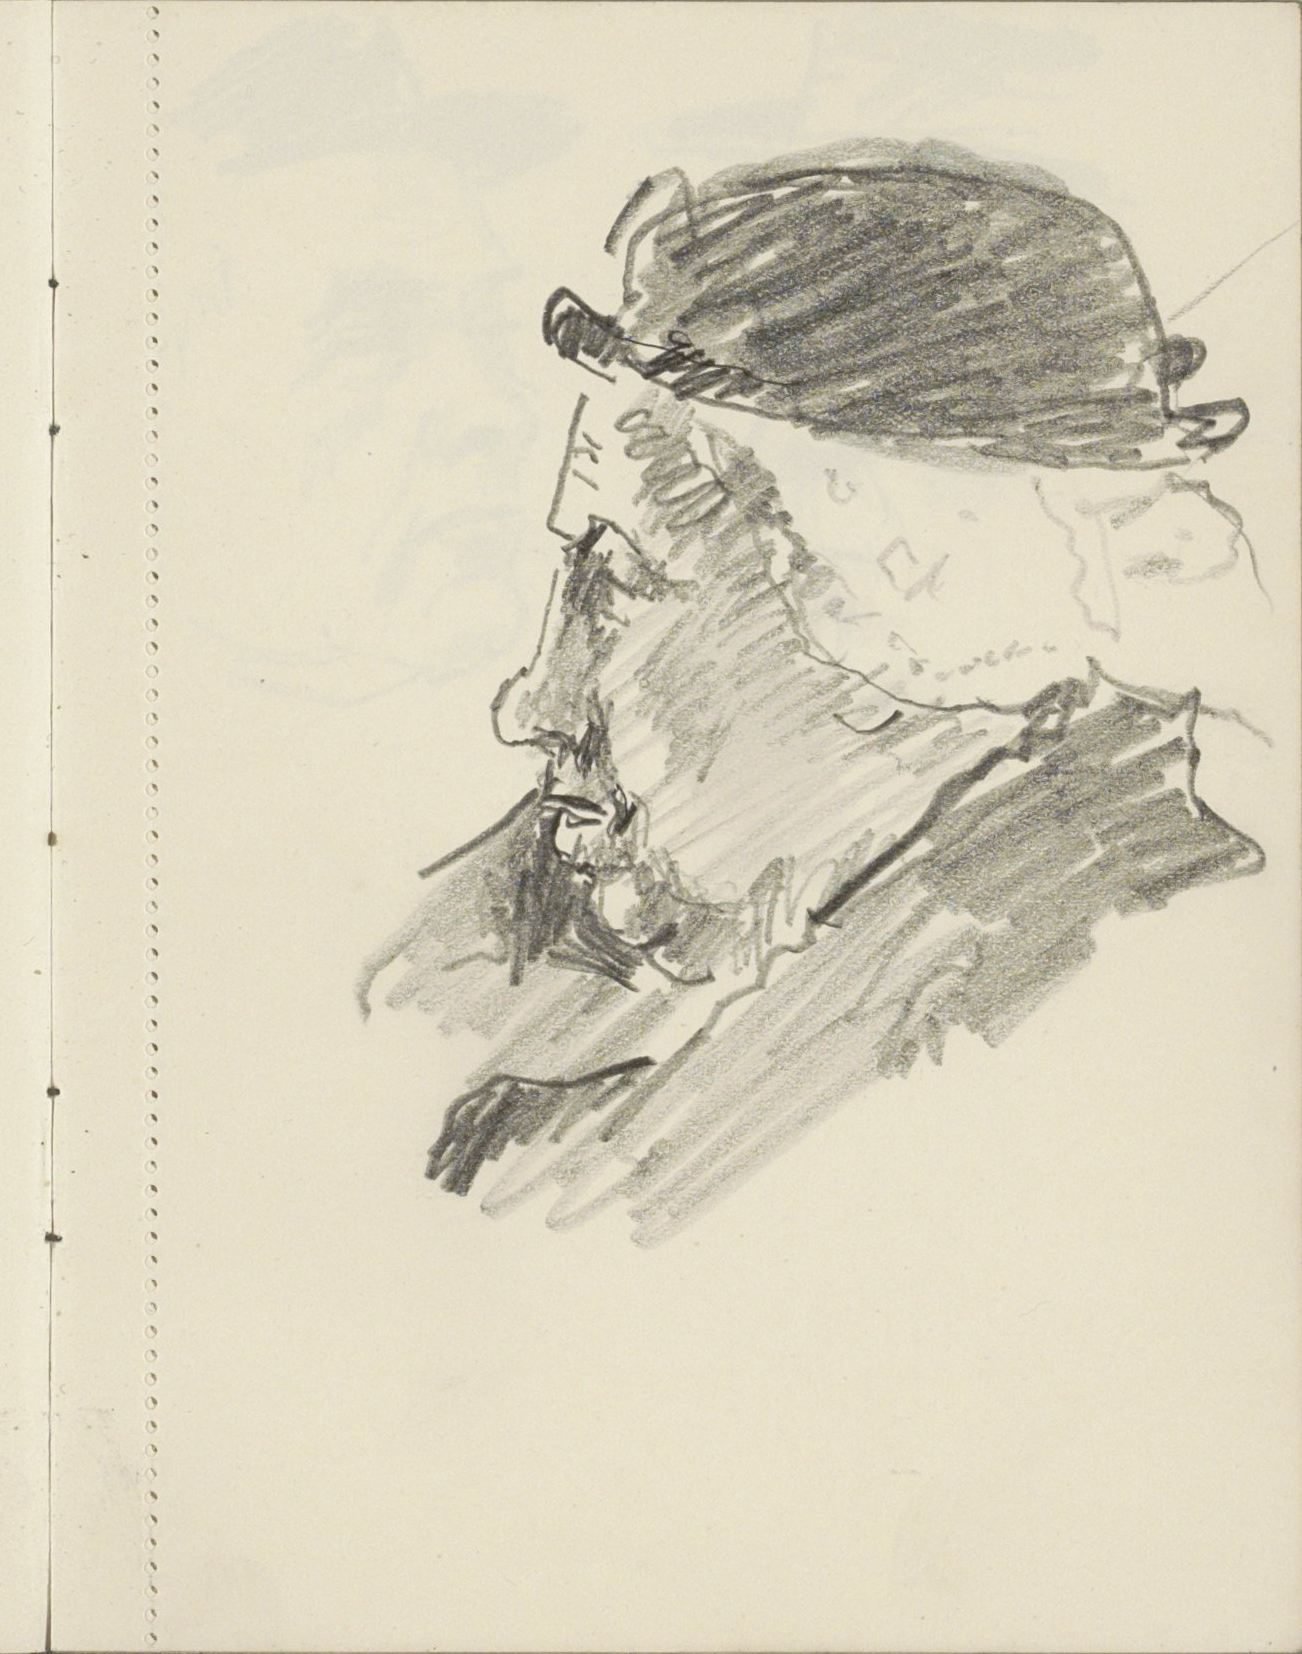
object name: sketchbook leaf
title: Kop van een oudere vrouw met een hoed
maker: cornelis vreedenburgh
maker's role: draughtsman, print maker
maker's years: 1880-1946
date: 1890-1946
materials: paper, pencil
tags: head (human) (+ old female (human being)), head-gear: hat (+ women's clothes)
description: Blad 16 recto uit een schetsboek met 71 bladen.